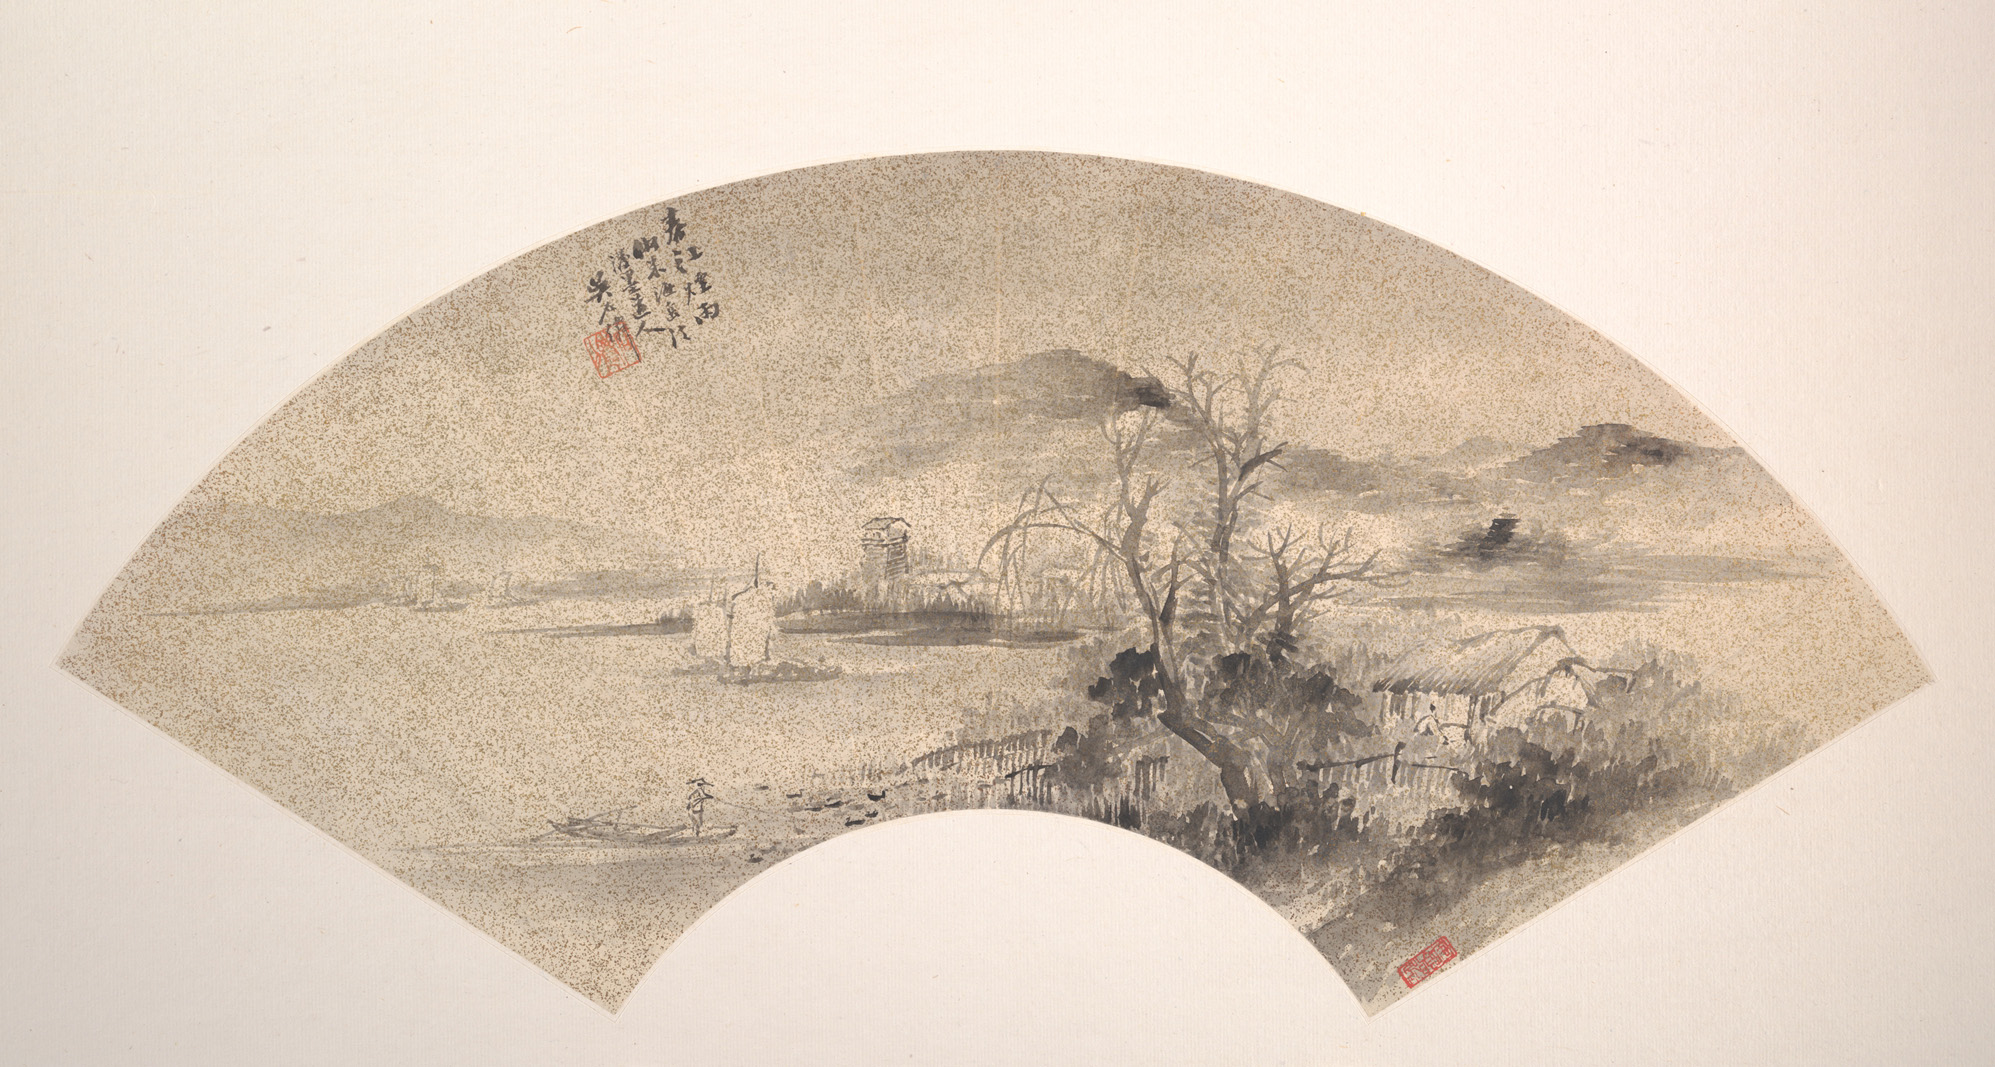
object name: folding fan mounted a an album leaf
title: Misty Rain on the River in Spring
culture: chinese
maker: wu shixian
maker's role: artist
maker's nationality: chinese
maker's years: -1916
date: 1816-1916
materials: gold, ink, paper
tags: rivers,landscapes